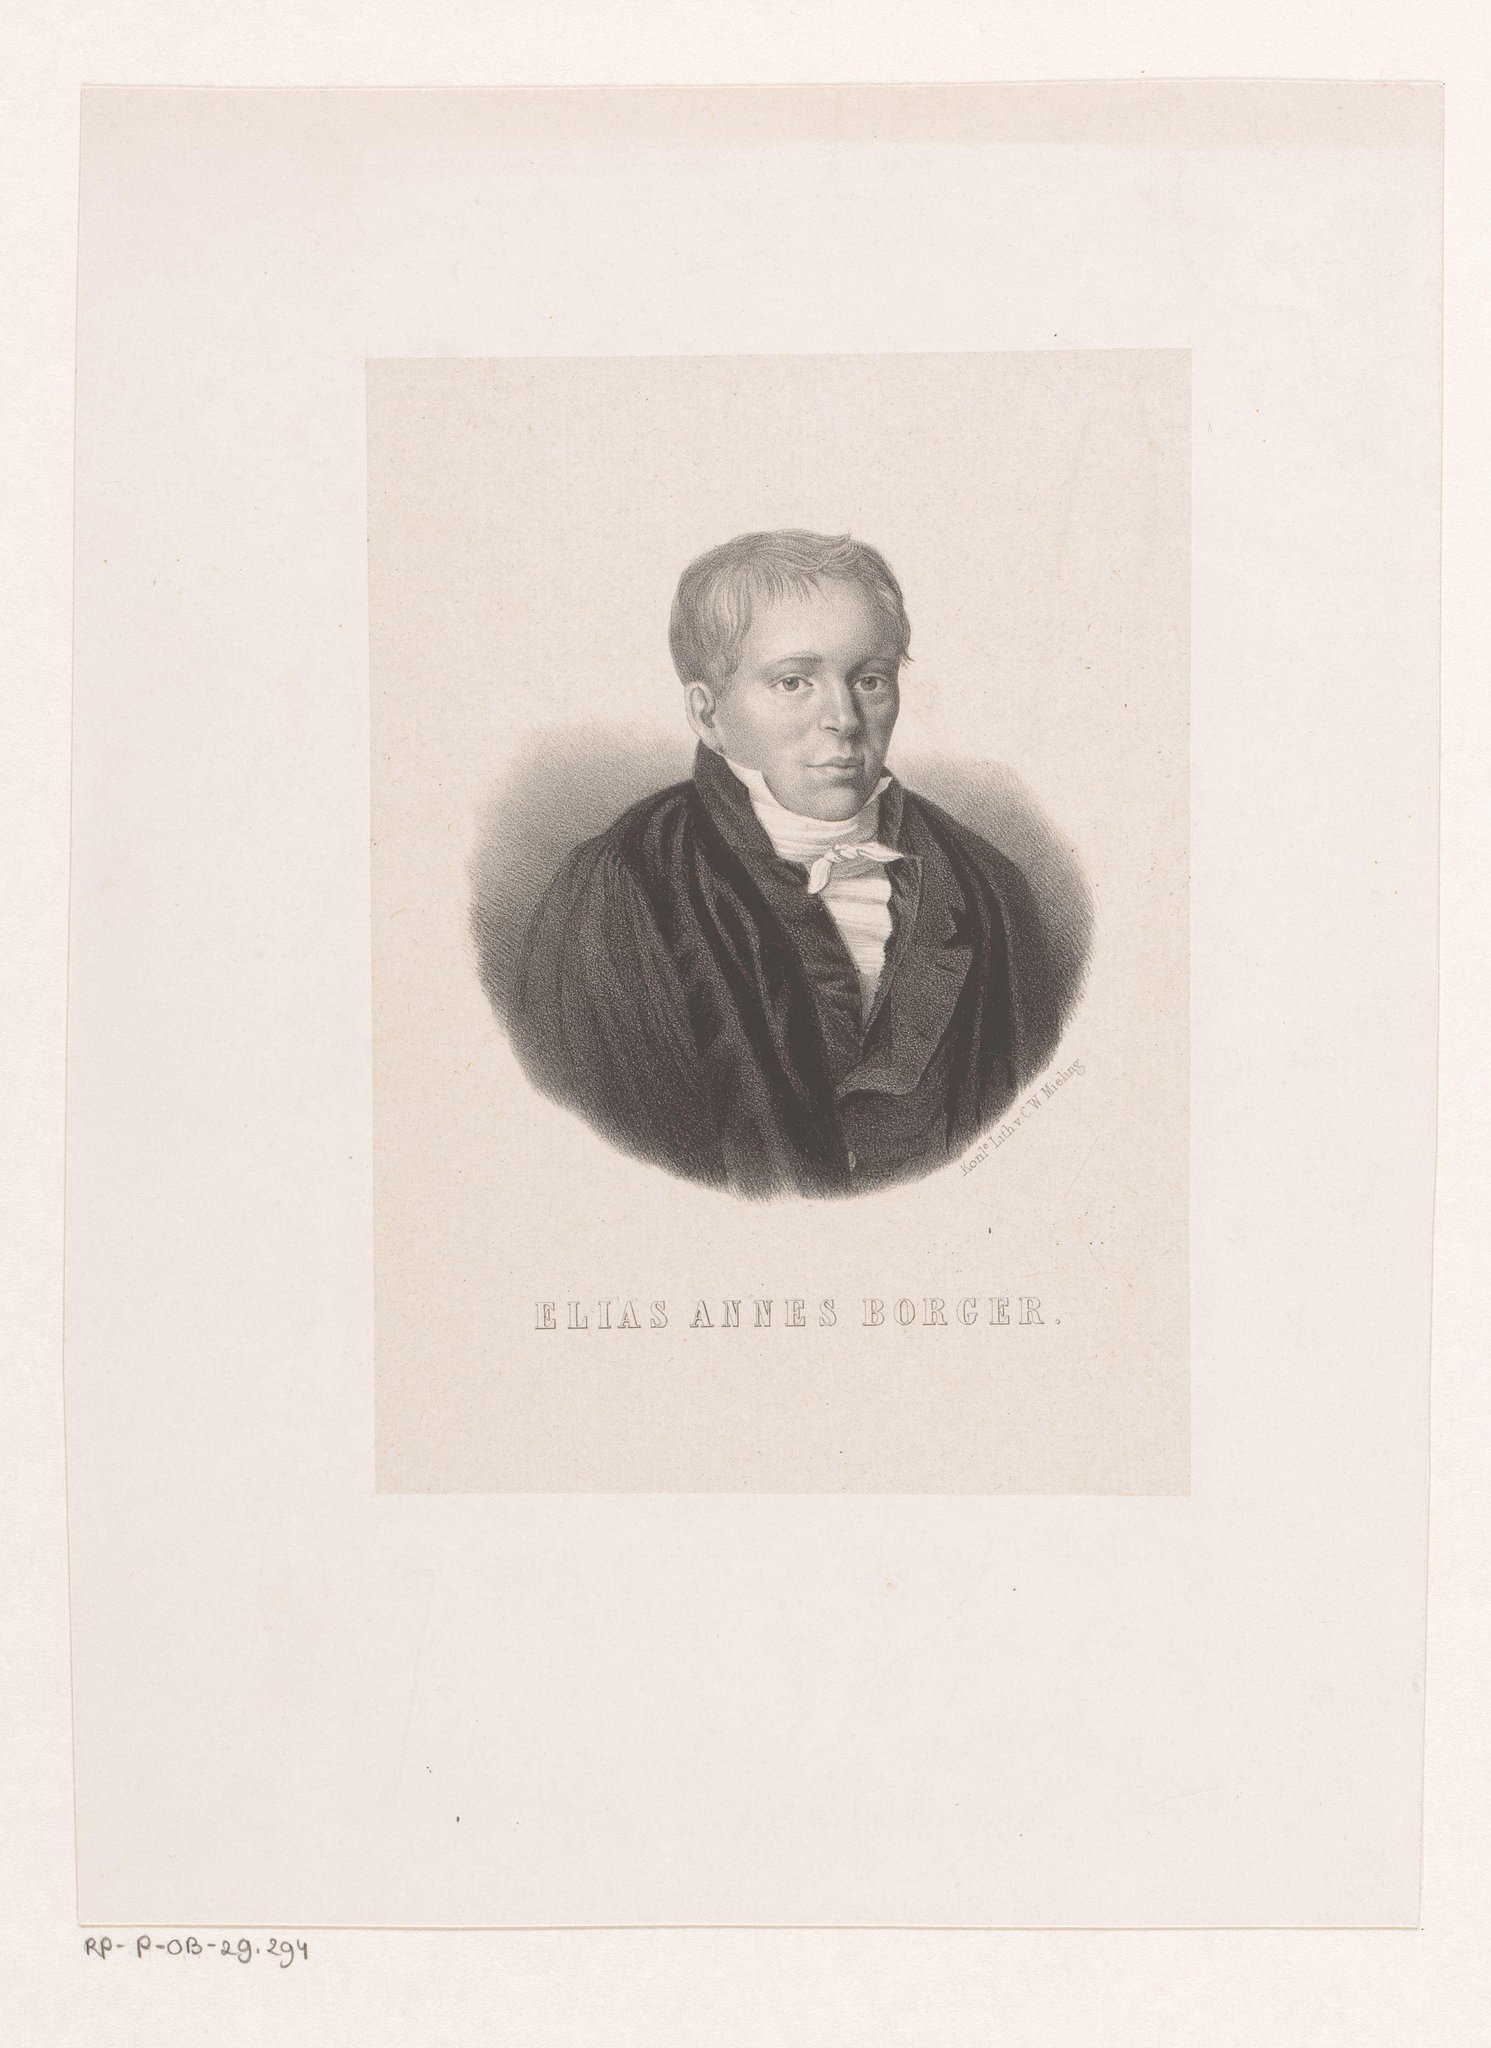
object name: print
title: Portret van Elias Annes Borger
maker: Anonymous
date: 1847-1865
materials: paper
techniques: lithograph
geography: the hague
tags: historical persons (+ (full) bust portrait)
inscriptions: collector's mark: Lugt 2228